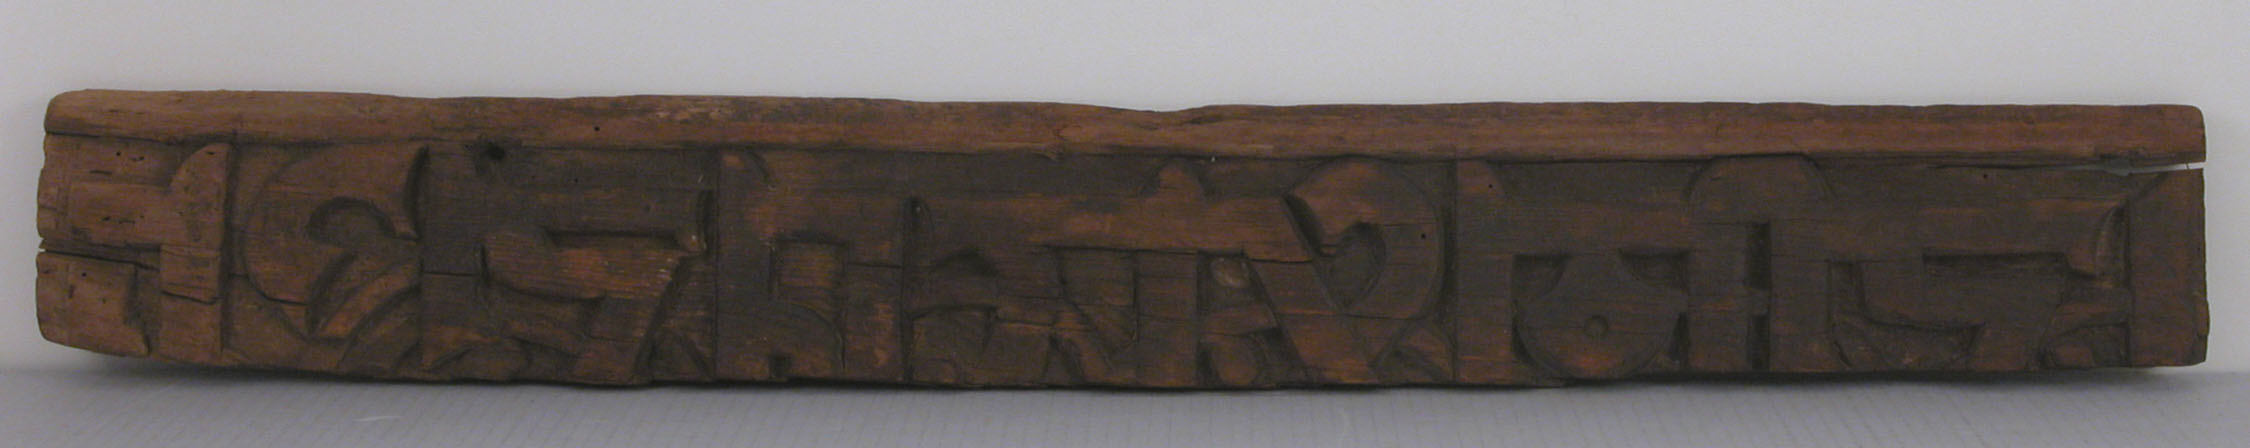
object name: panel fragment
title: Fragment of a Panel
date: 901-1000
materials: wood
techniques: carving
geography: egypt